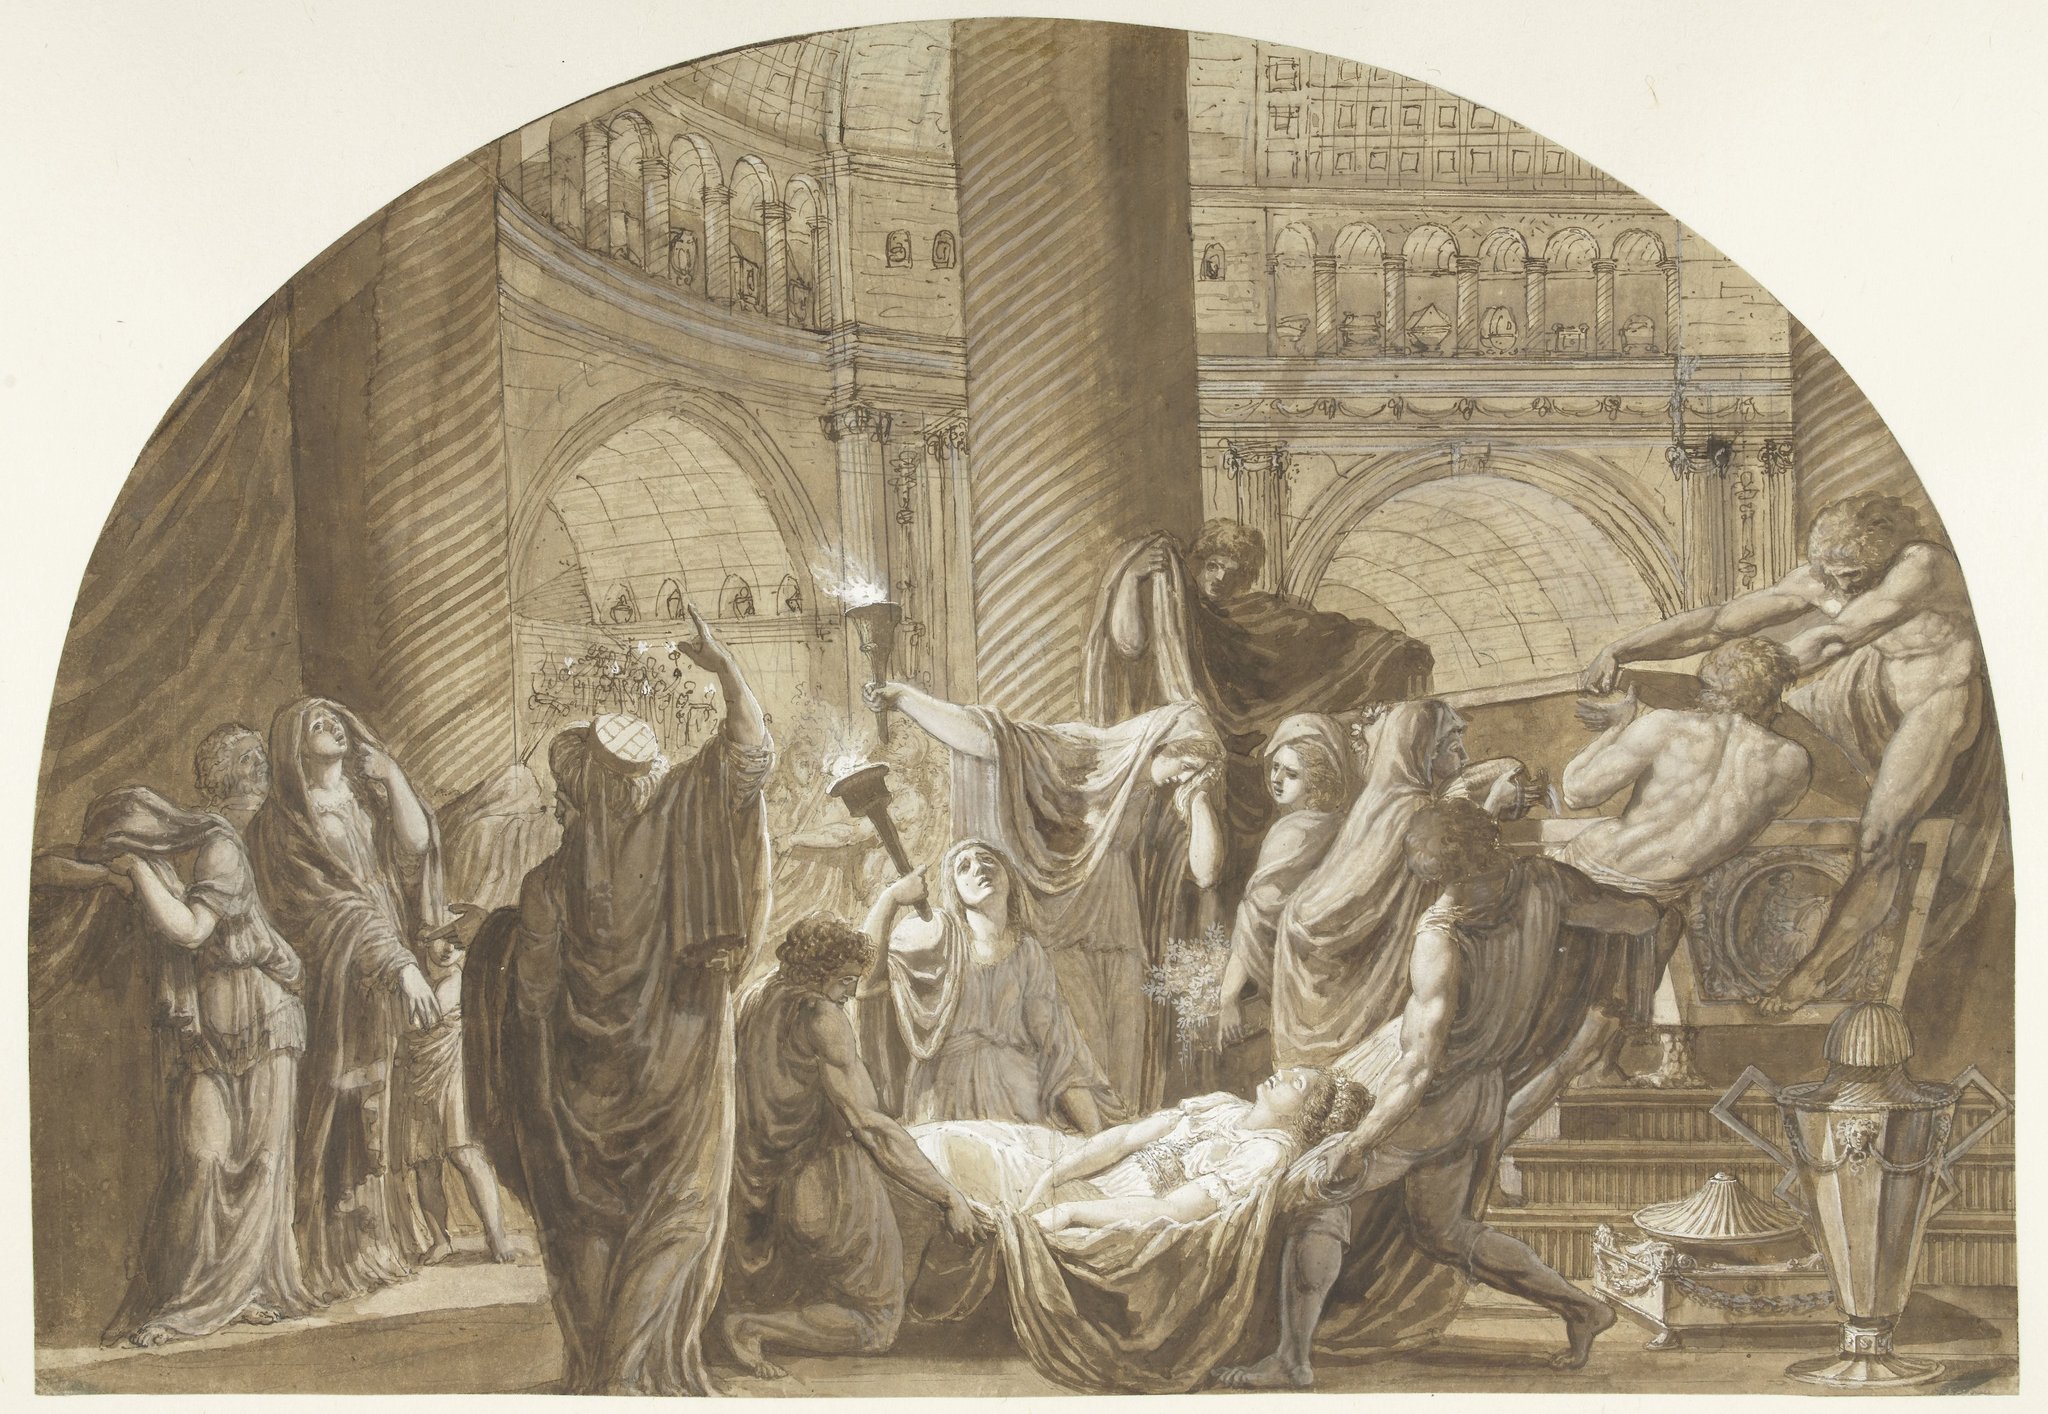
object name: drawing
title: Antique Funeral Scene in a Mausoleum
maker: luigi ademollo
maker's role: draughtsman, painter, print maker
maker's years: 1764-1849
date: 1795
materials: ink, paint, paper, pencil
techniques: brush, pen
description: Compositions depicting history scenes posed the greatest challenge for Neoclassical artists. The fierce competition among them meant that they continually had to find and depict original, lesser-known themes. It is not known which story is depicted here. A dead woman is being carried to a sarcophagus. The composition is well-conceived with the men displaying their brawn and the women their great sorrow.